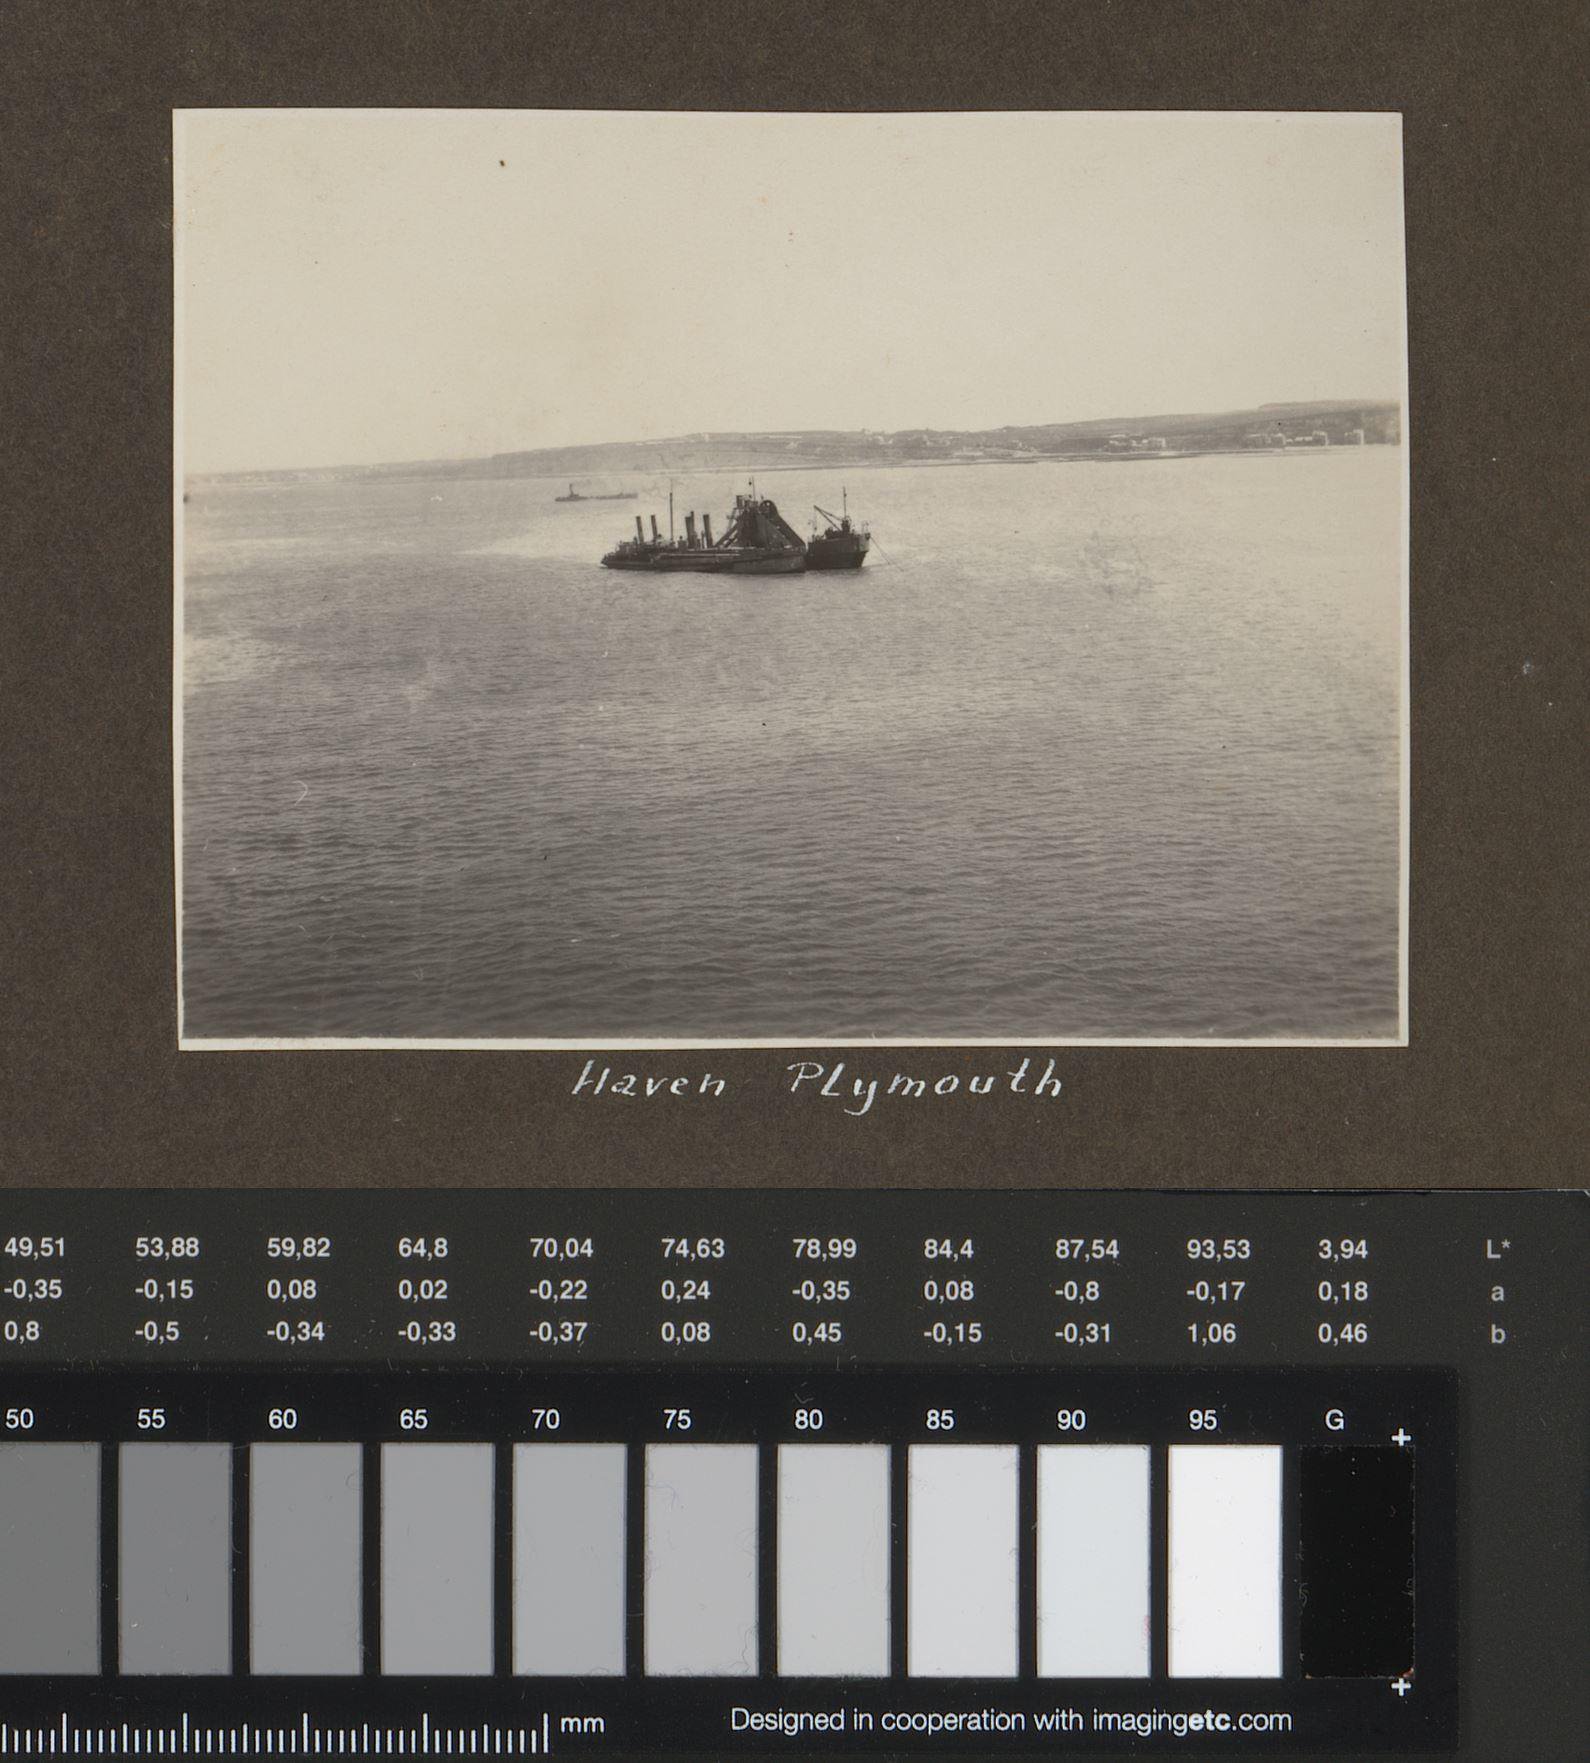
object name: photograph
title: Schip met op de achtergrond de haven van Plymouth gezien vanaf het water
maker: Anonymous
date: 1928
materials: photographic support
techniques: gelatin silver print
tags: harbour, ships (in general), new york (city)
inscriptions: annotation: ‘Haven Plymouth’